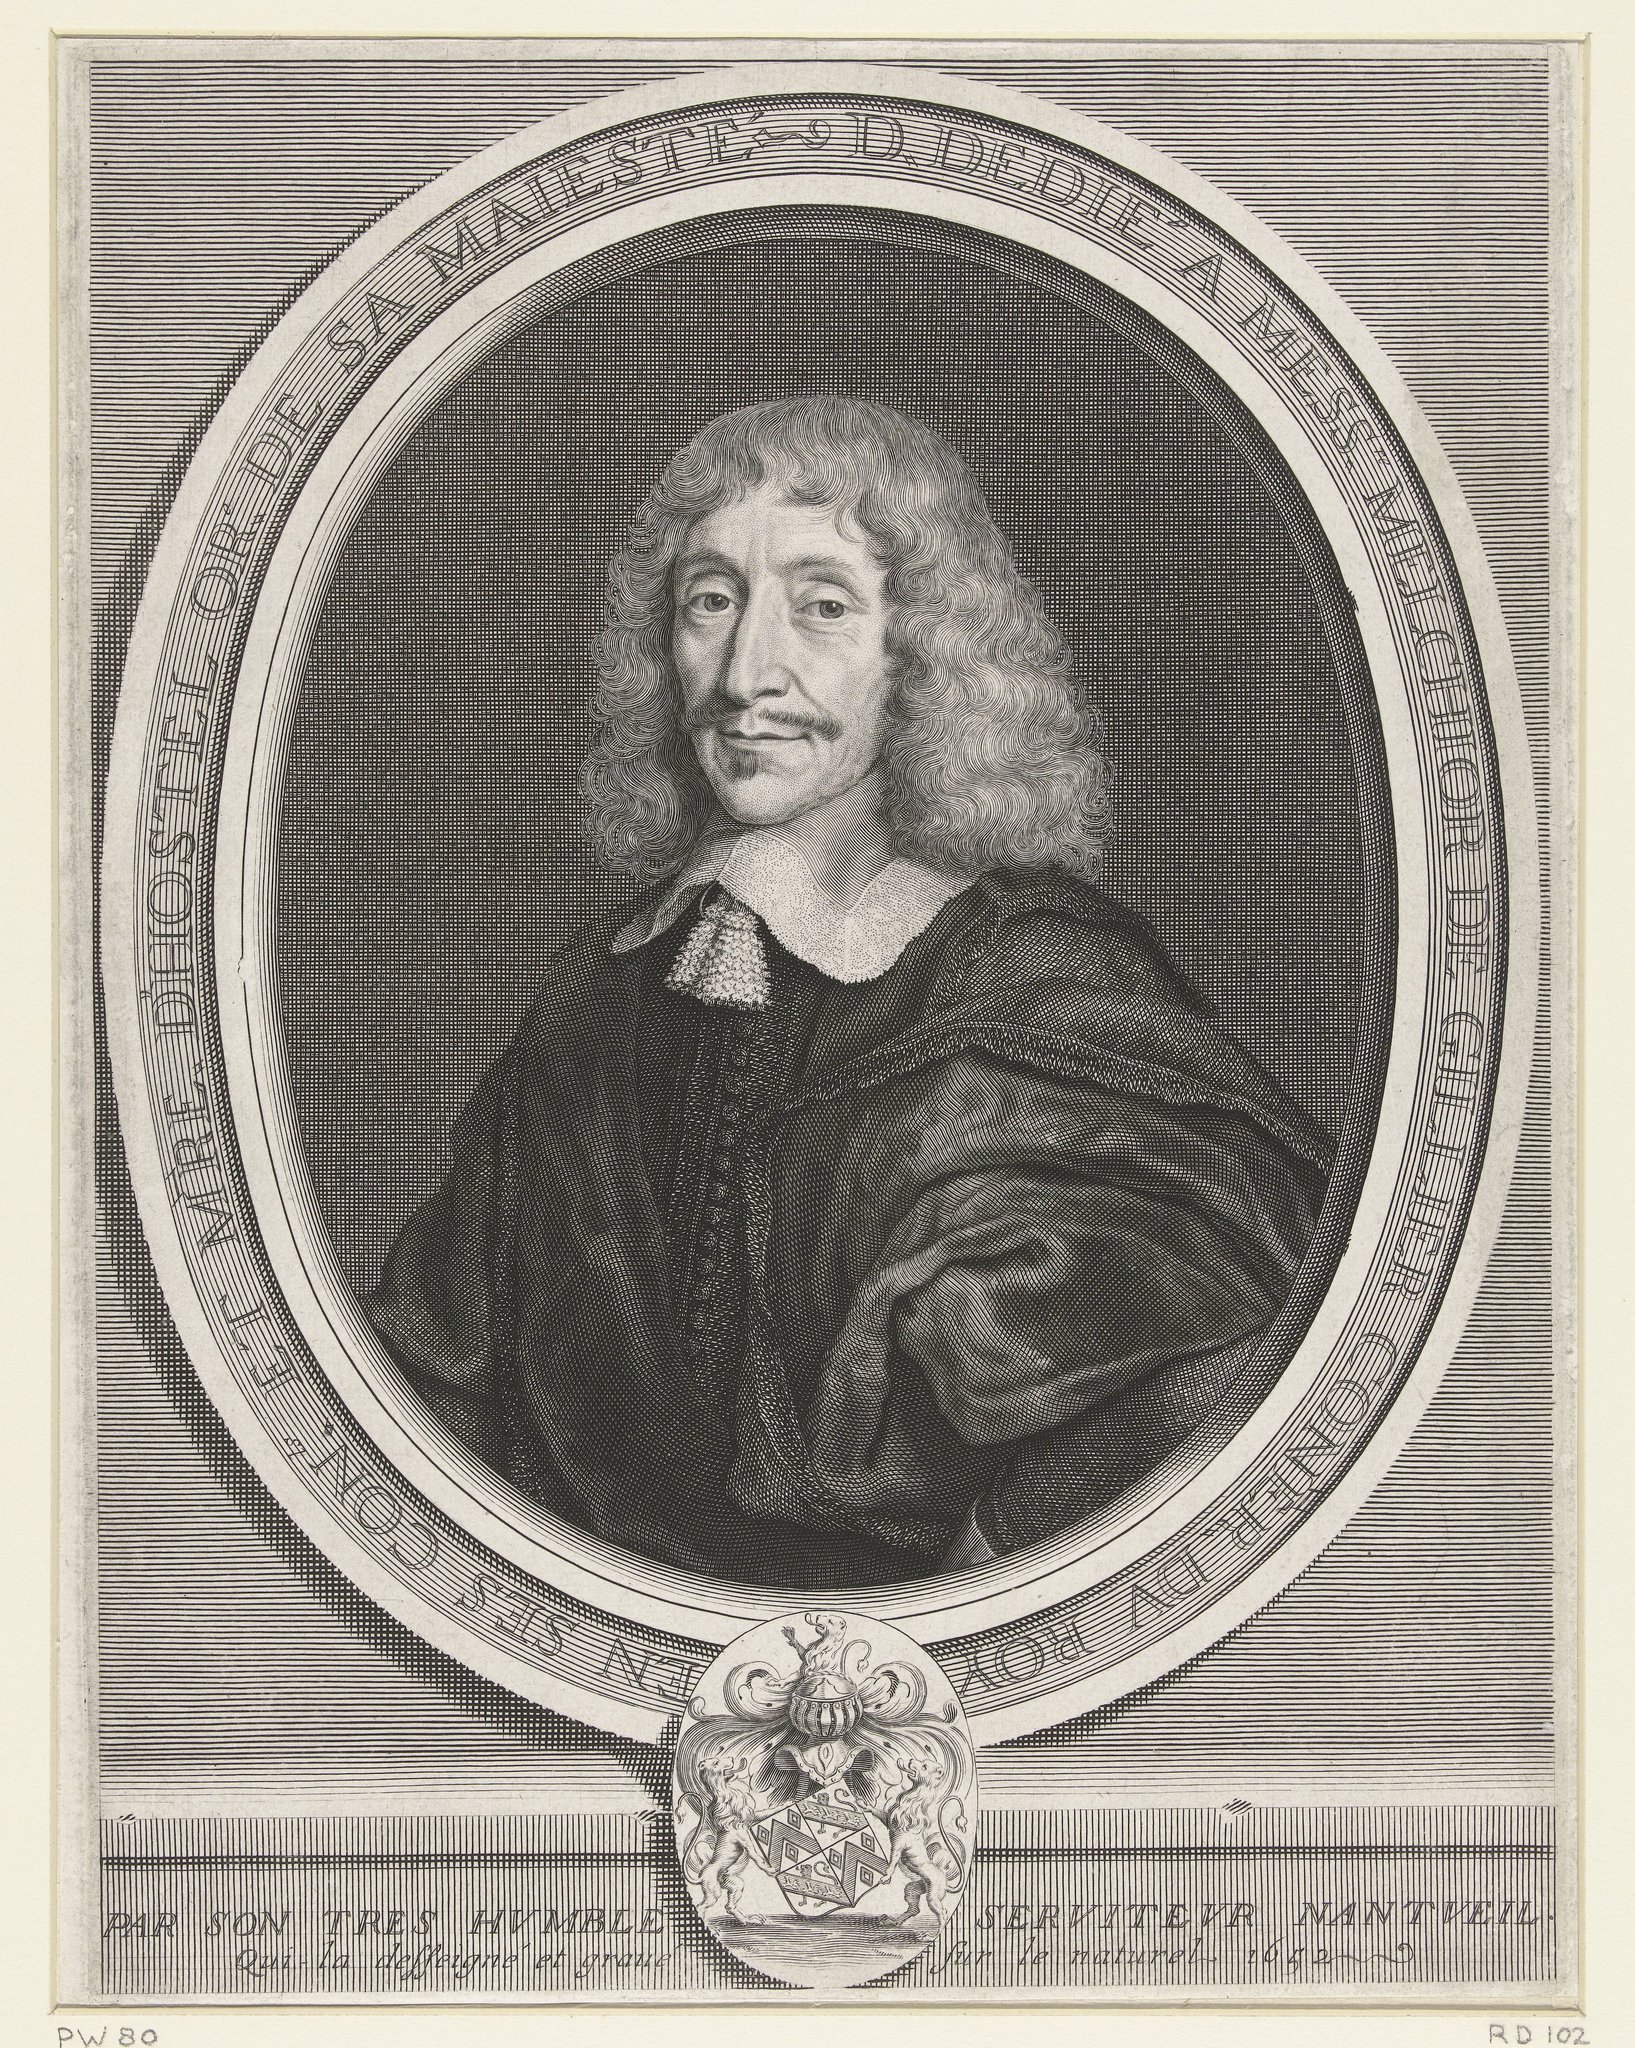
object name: print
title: Portret van Melchior de Gillier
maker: robert nanteuil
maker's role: print maker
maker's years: 1623-1678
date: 1652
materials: paper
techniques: engraving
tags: melchior de gillier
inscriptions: collector's mark: Lugt 2228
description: Portret van Melchior de Gillier, heer de Lagny, met een hand in zijn zij. Een ovale omlijsting met tekst en en wapenschild, staand op een voetstuk met een tweeregelige tekst in het Frans.